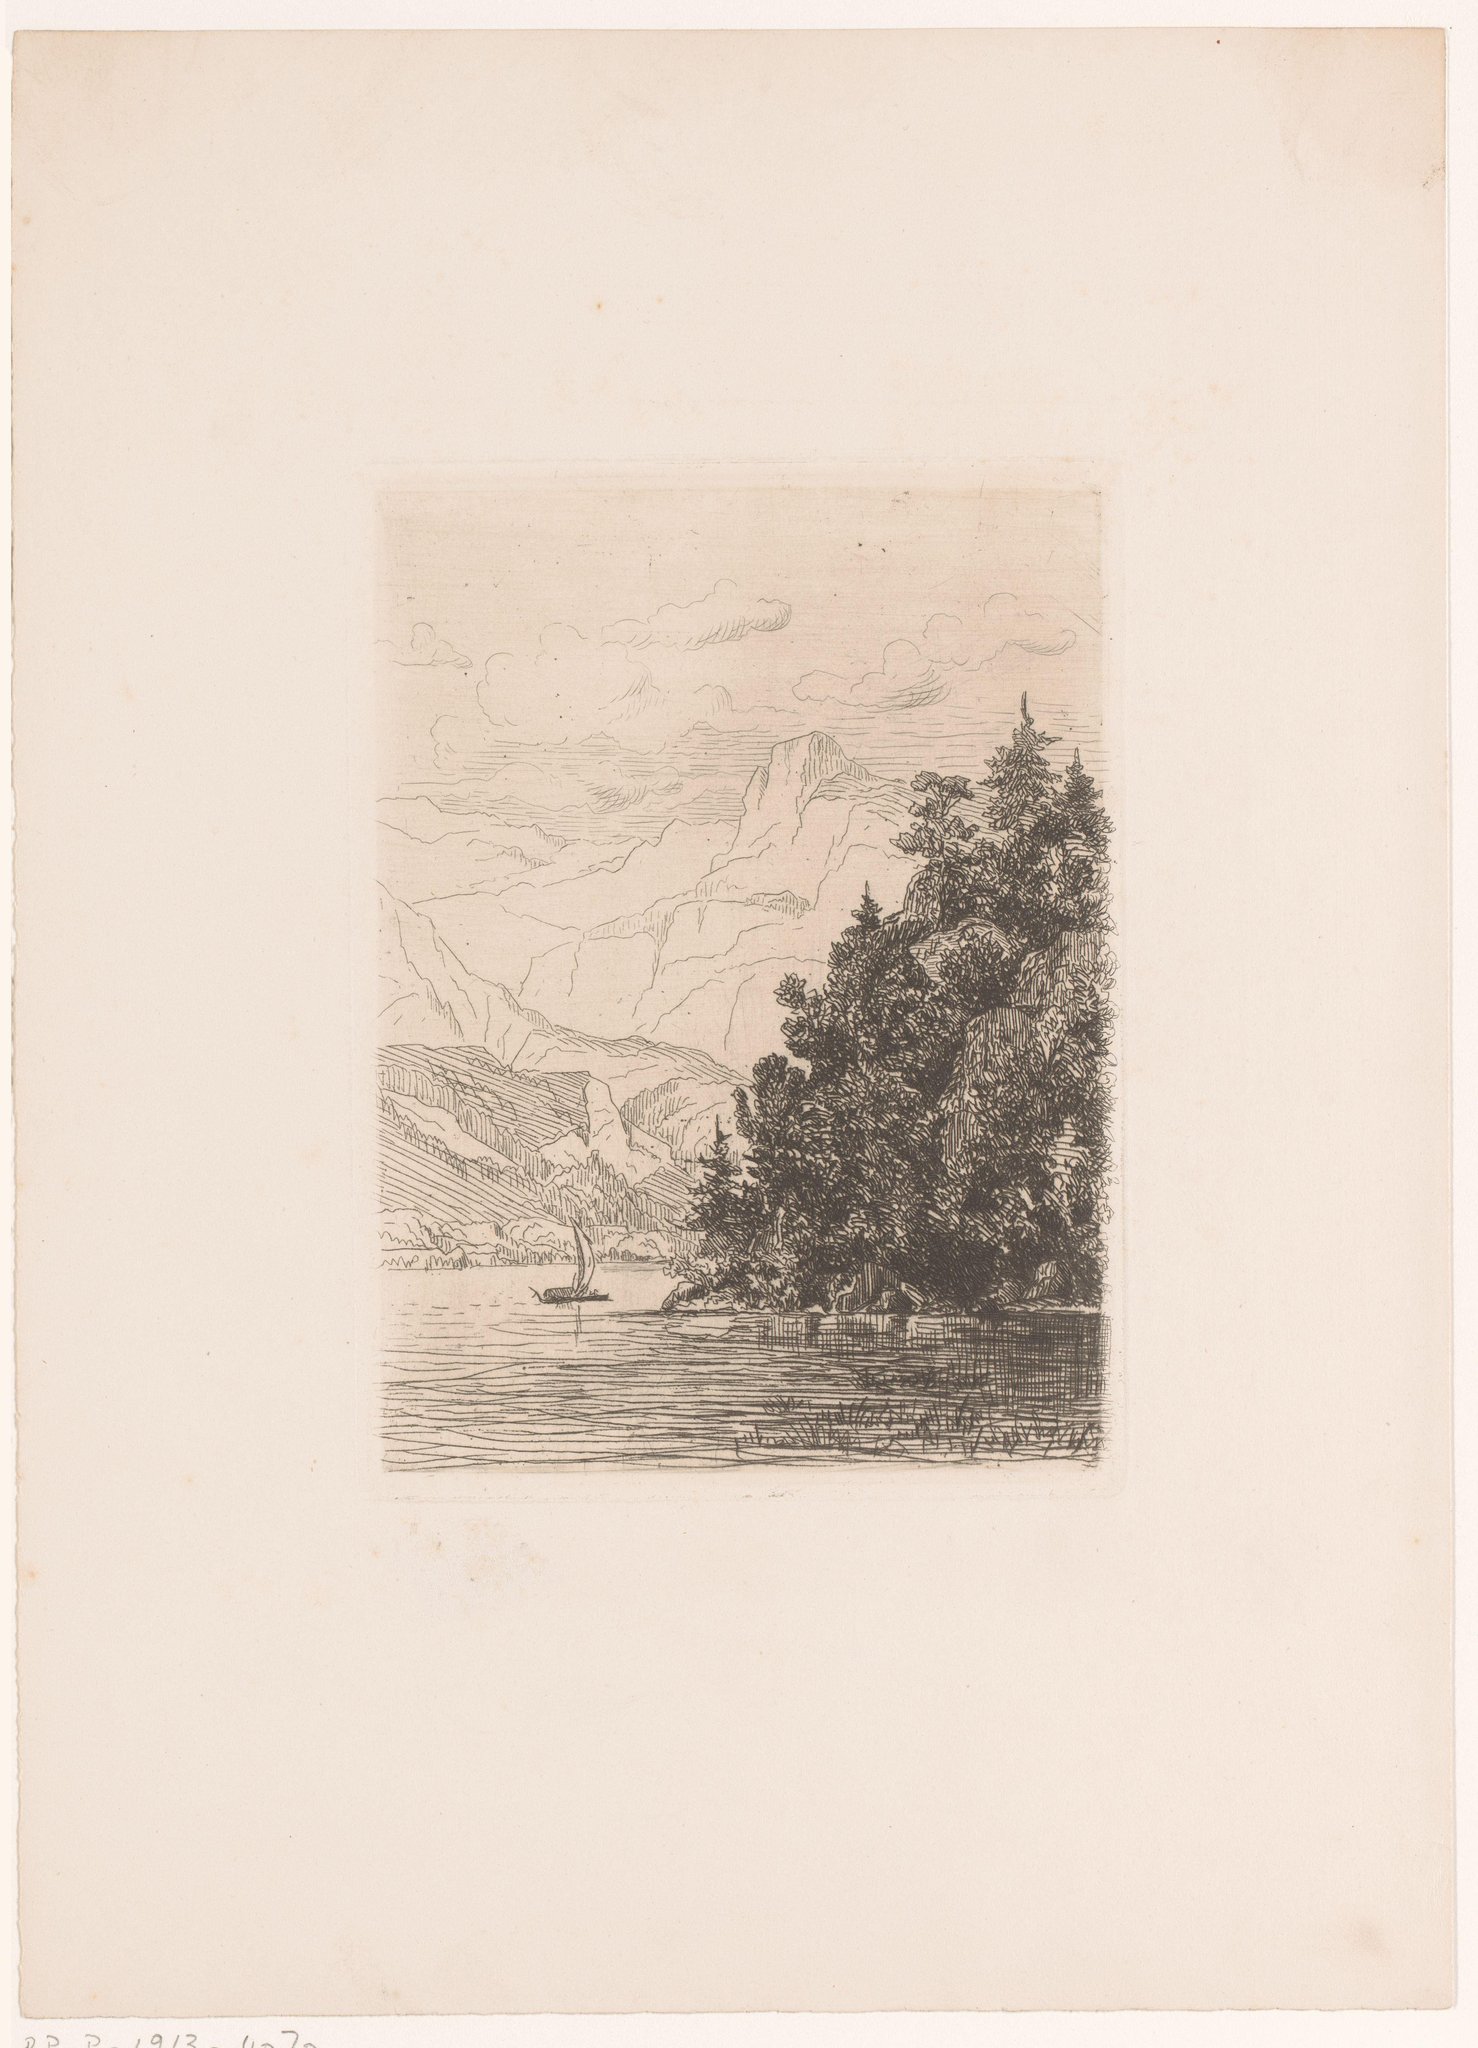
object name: print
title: Gezicht op een meer in de bergen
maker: maria van hohenzollern-sigmaringen (gravin van vlaanderen)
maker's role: print maker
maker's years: 1845-1912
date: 1868-1912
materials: paper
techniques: drypoint, etching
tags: lake, mountains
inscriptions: collector's mark: Lugt 2228